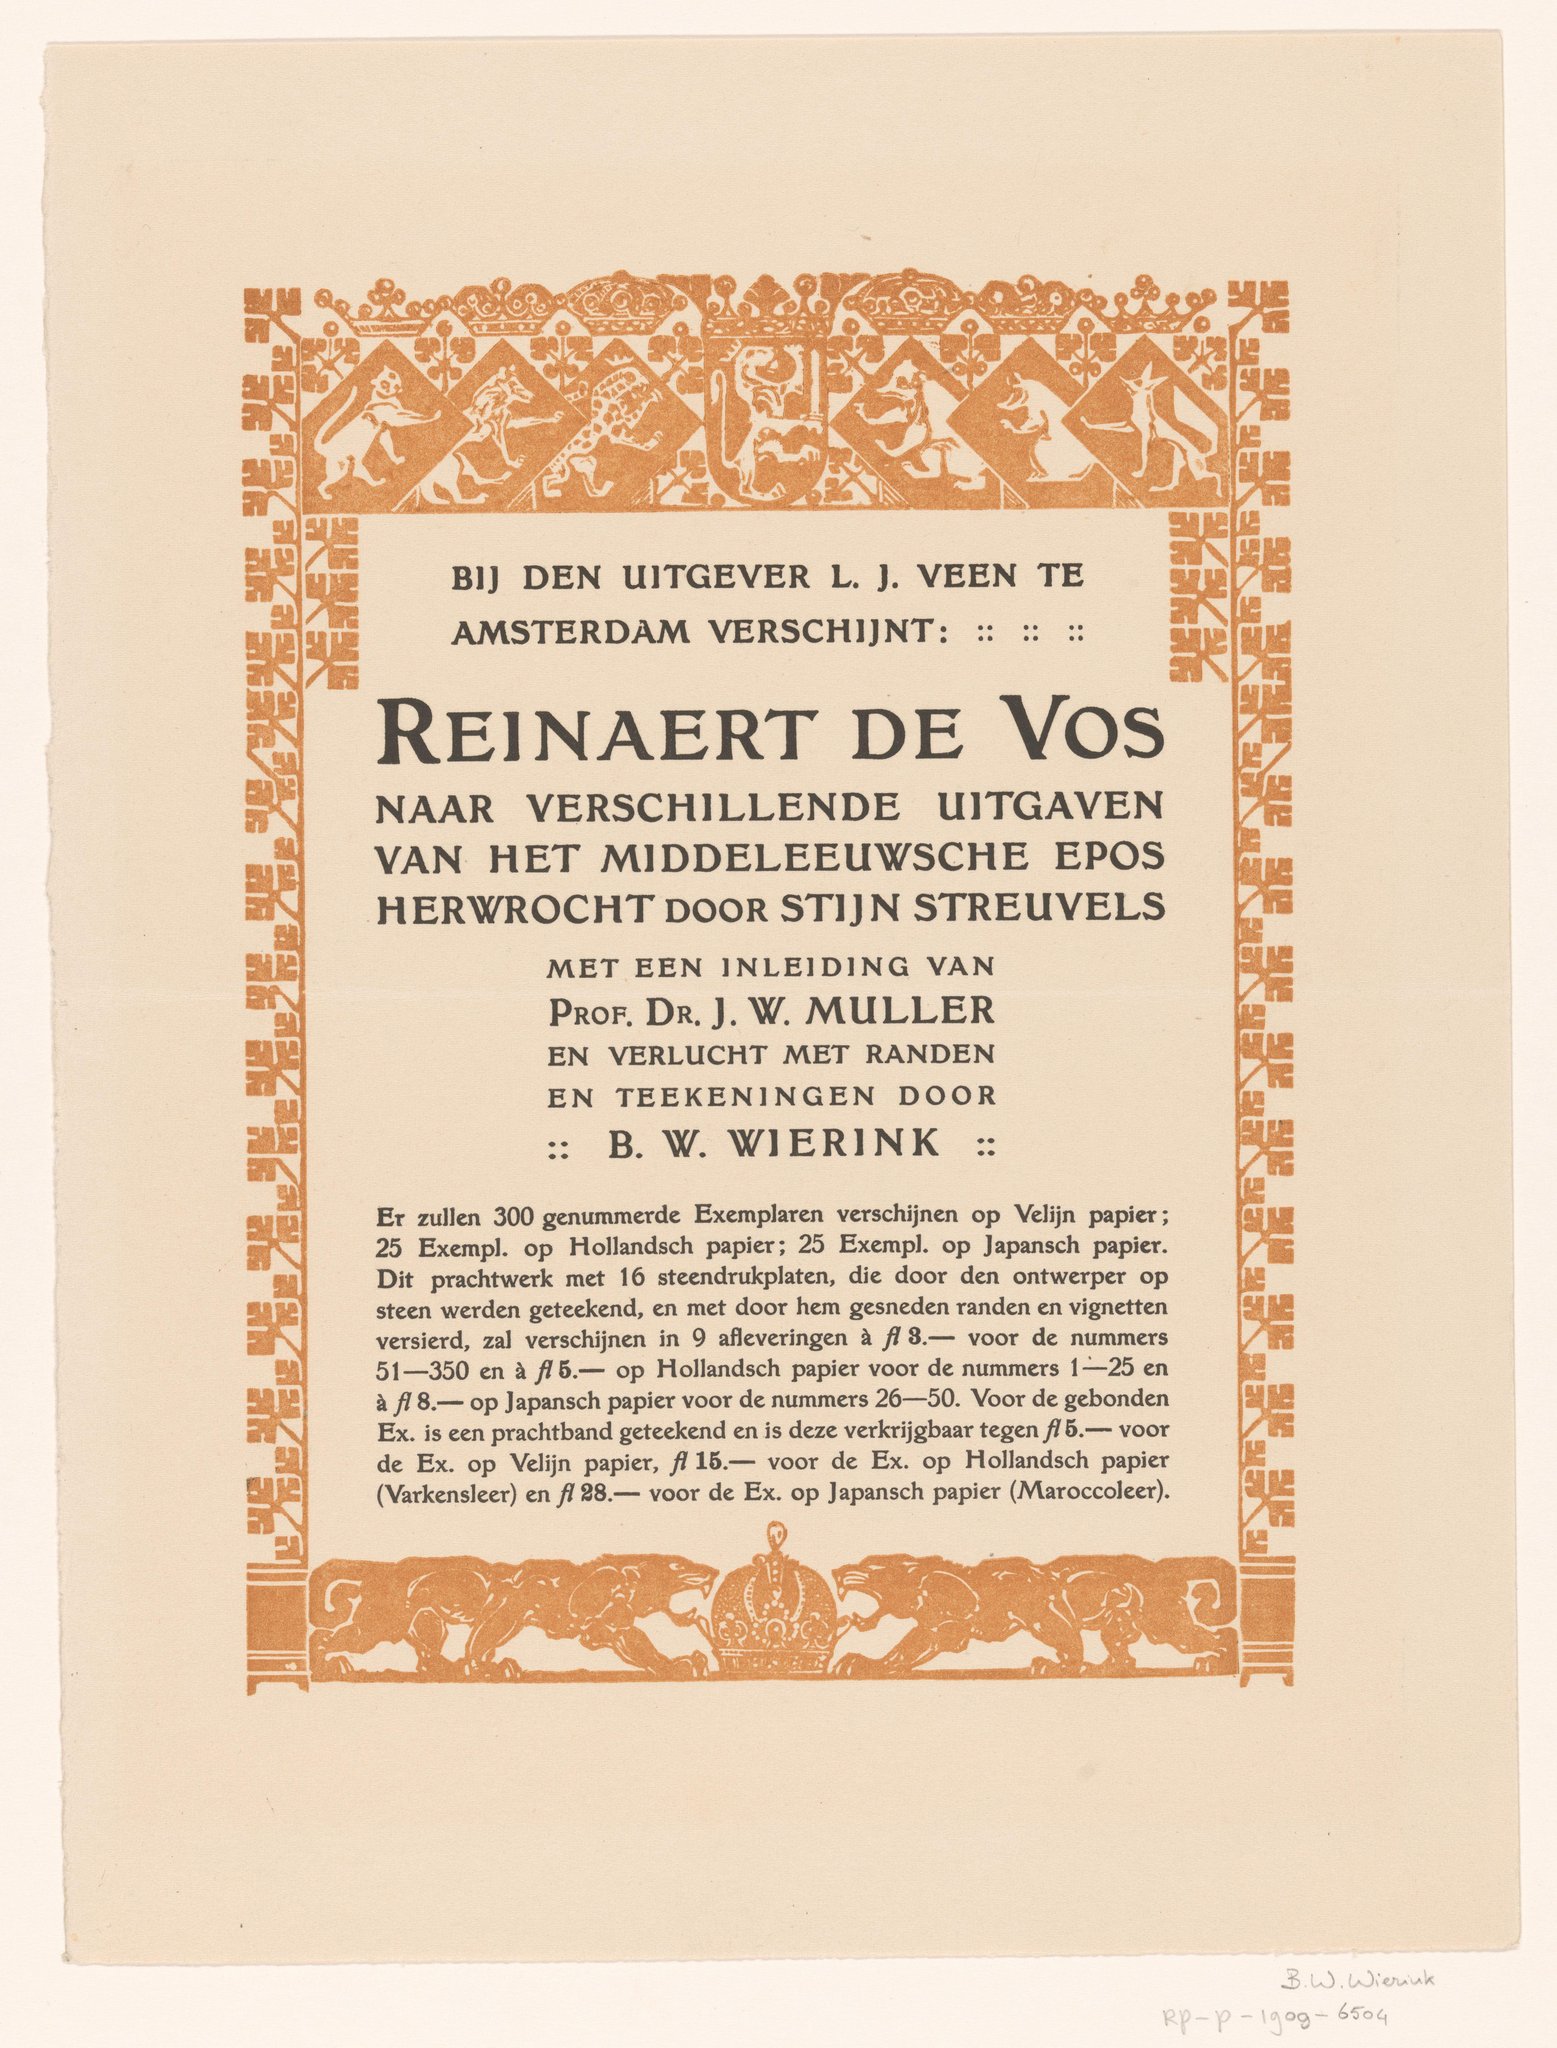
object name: print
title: Advertentie voor Reinaert de Vos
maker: bernard willem wierink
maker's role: draughtsman, print maker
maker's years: 1856-1939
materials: paper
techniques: relief print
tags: advertisement, notice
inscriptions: collector's mark: Lugt 2228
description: Deze prent is vermoedelijk een plaatsnede, ook al wordt in de literatuur veelal gesproken over een houtsnede. Voor zover Wierink zijn prenten in hoogdruk zelf nader heeft omschreven, heeft hij altijd de term 'plaatsnede' gebruikt.